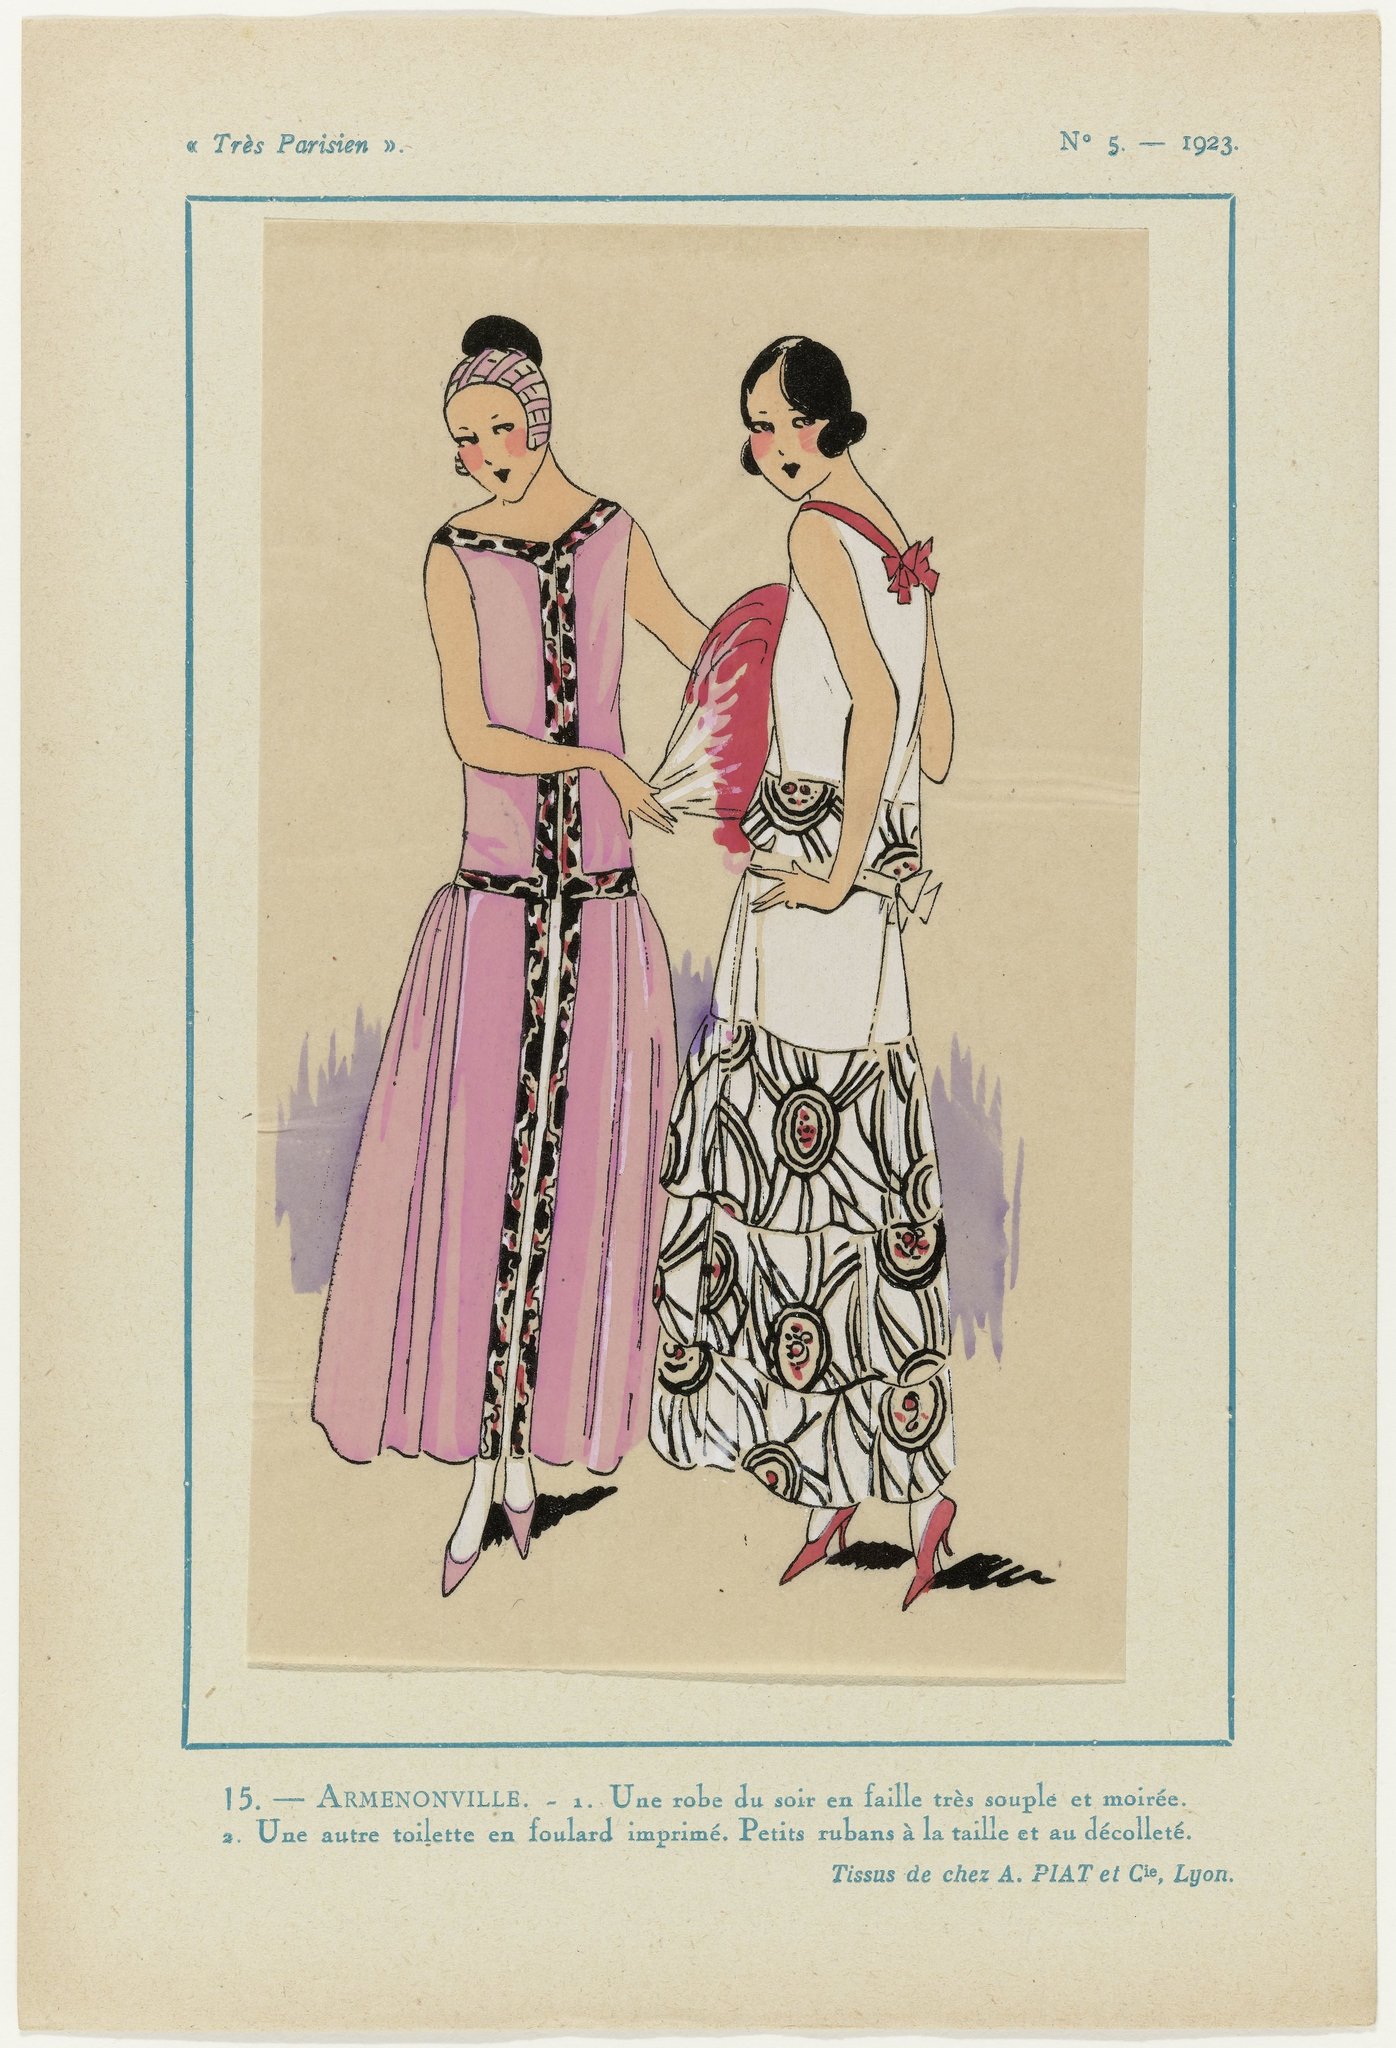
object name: fashion print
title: Très Parisien, 1923, No 5: 15.- ARMENONVILLE. - 1. Une robe du soir...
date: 1923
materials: paper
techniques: hand coloring, letterpress printing, lithography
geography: lyon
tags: dress, gown: evening dress (+ women's clothes), border, ribbon, braid (+ women's clothes), fashion plates, head-gear: hat (+ women's clothes), fan (+ women's clothes)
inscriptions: title: ‘Très Parisien / No 5. - 1923’, caption: ‘15. - ARMENONVILLE. - 1. Une robe du soir en faille très souple et moirée. 2. Une autre toilette en foulard imprimé. Petits rubans à la taille et au décolleté. / Tissus de chez A. PIAT et Cie, Lyon.’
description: 1. Een avondjurk van soepele 'faille' en moiré (zijde?). 2. Een ander 'toilette' van bedrukte foulard. Kleine linten bij de taille en de halslijn. Stoffen van A. Piat et Cie. Prent uit het modetijdschrift Très Parisien (1920-1936).